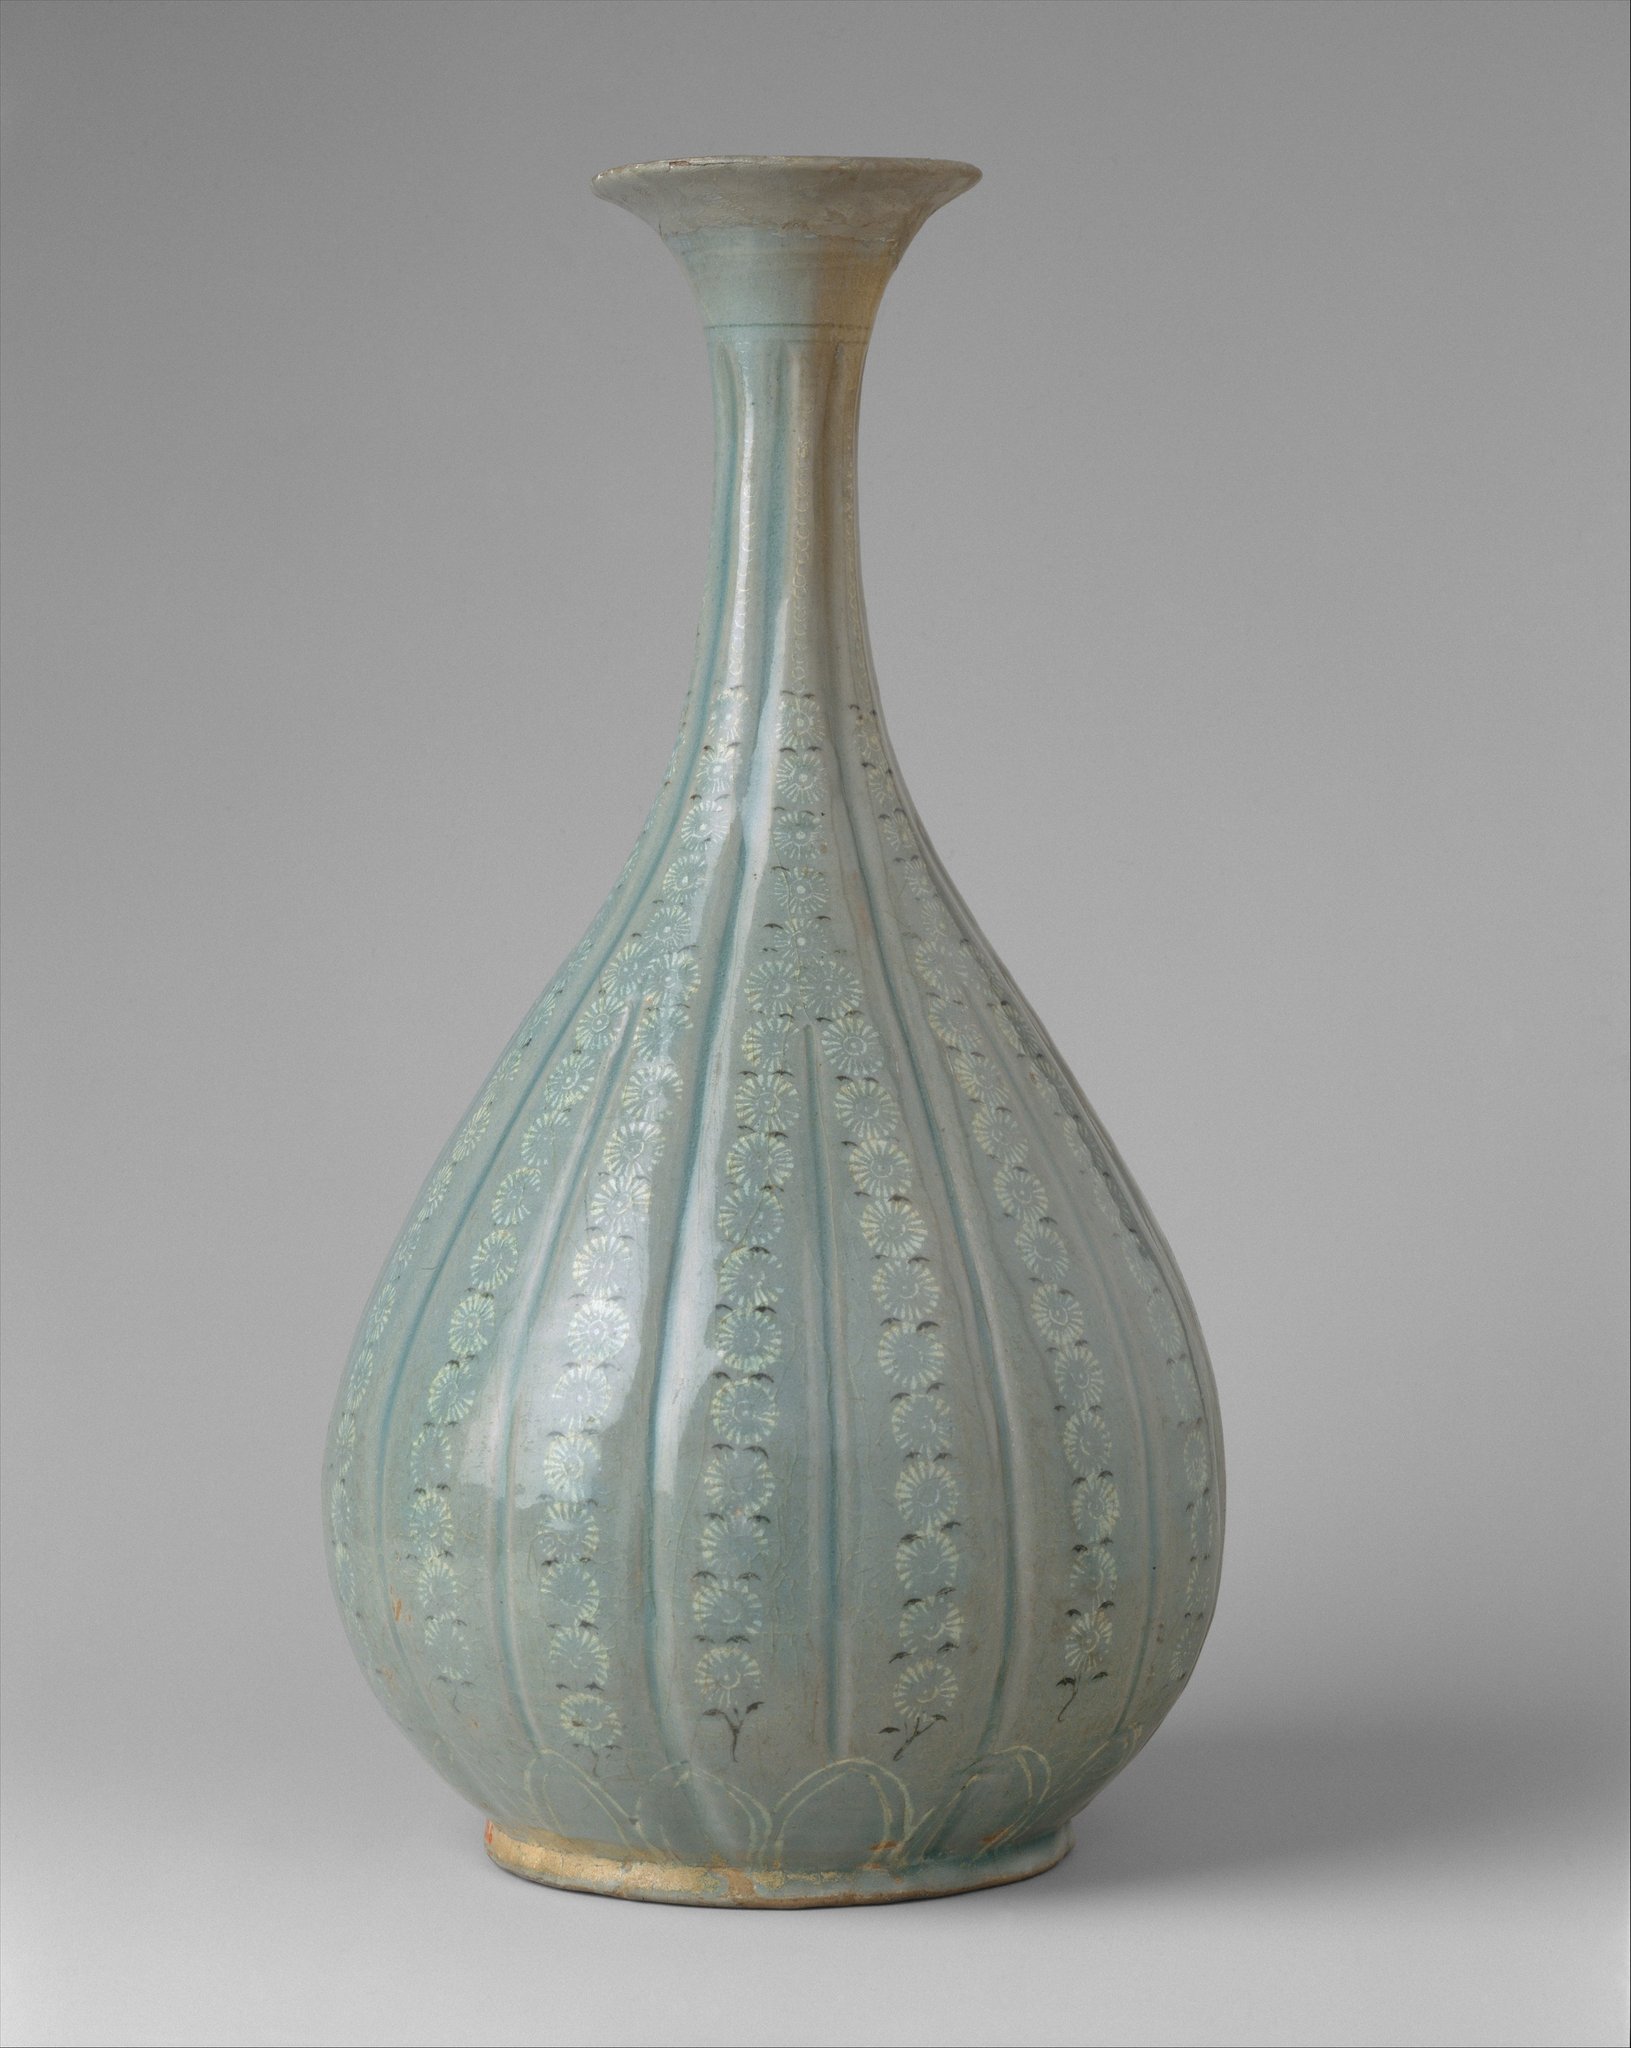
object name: bottle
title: Bottle decorated with chrysanthemums and lotus petals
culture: korean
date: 1267-1400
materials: ceramic glaze, glaze, stoneware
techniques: inlay, stamping